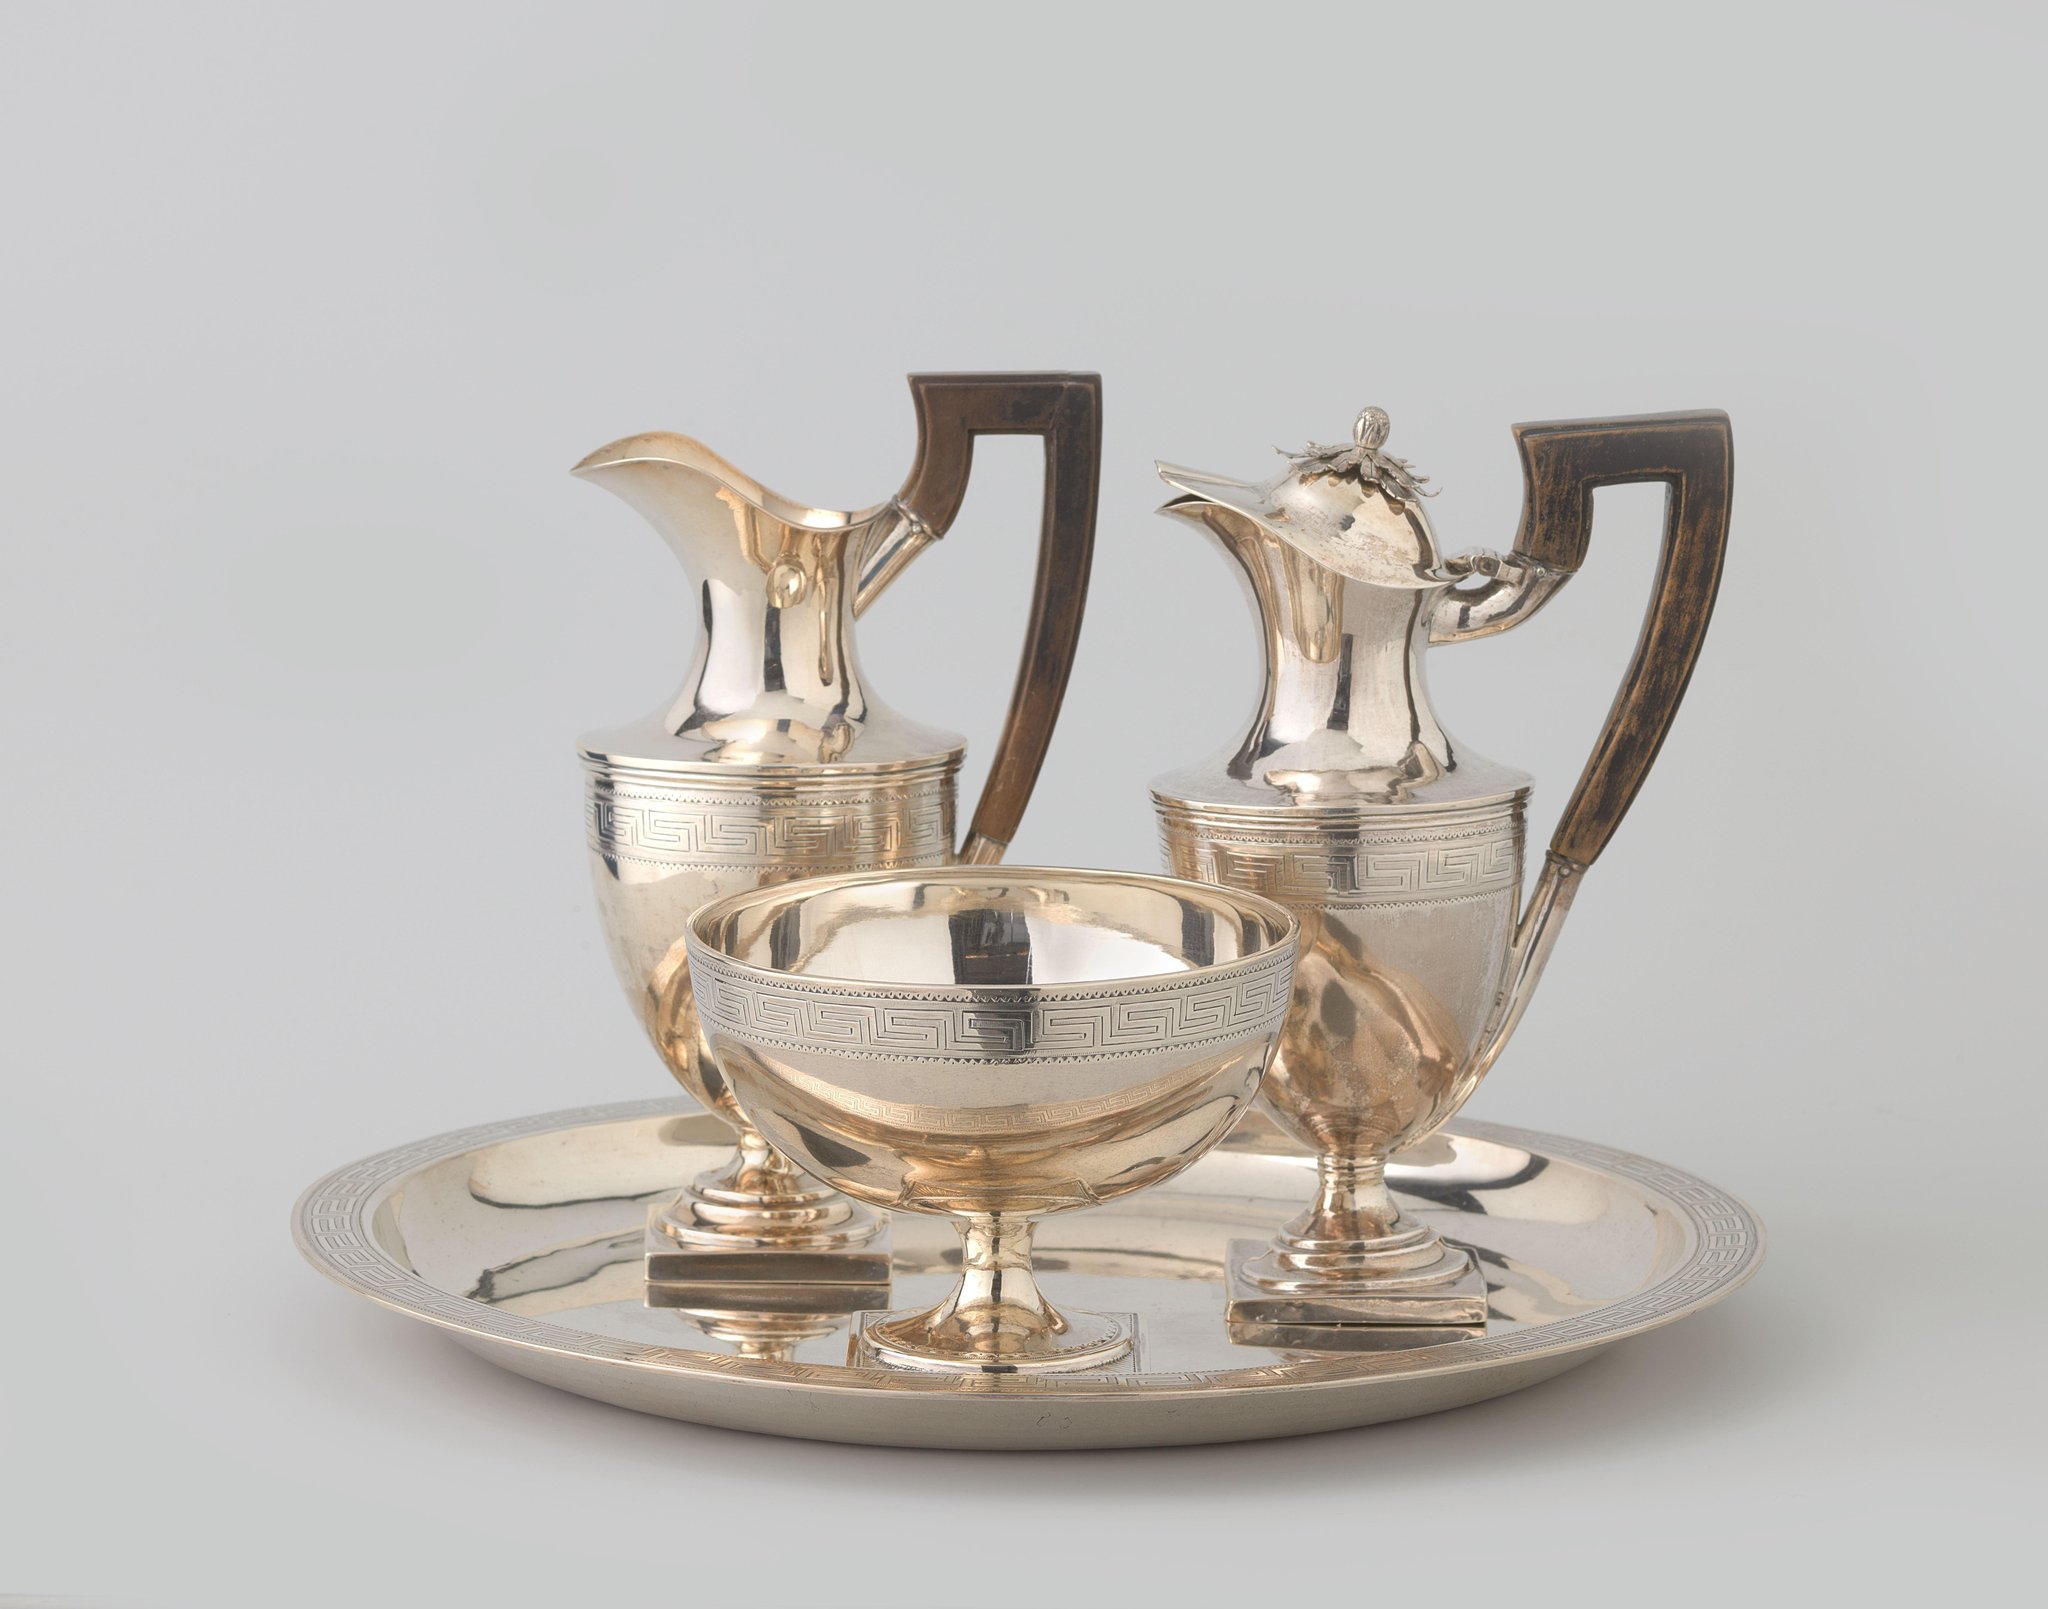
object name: vessel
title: Servies, bestaande uit een rond blad, een spoelkom, een kan en een melkkan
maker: Anonymous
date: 1785-1800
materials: silver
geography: lausanne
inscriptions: maker's mark: ‘APM’, alloy mark, town mark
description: Servies van zilver, bestaande uit een rond blad, een spoelkom, een kan en een melkkan.